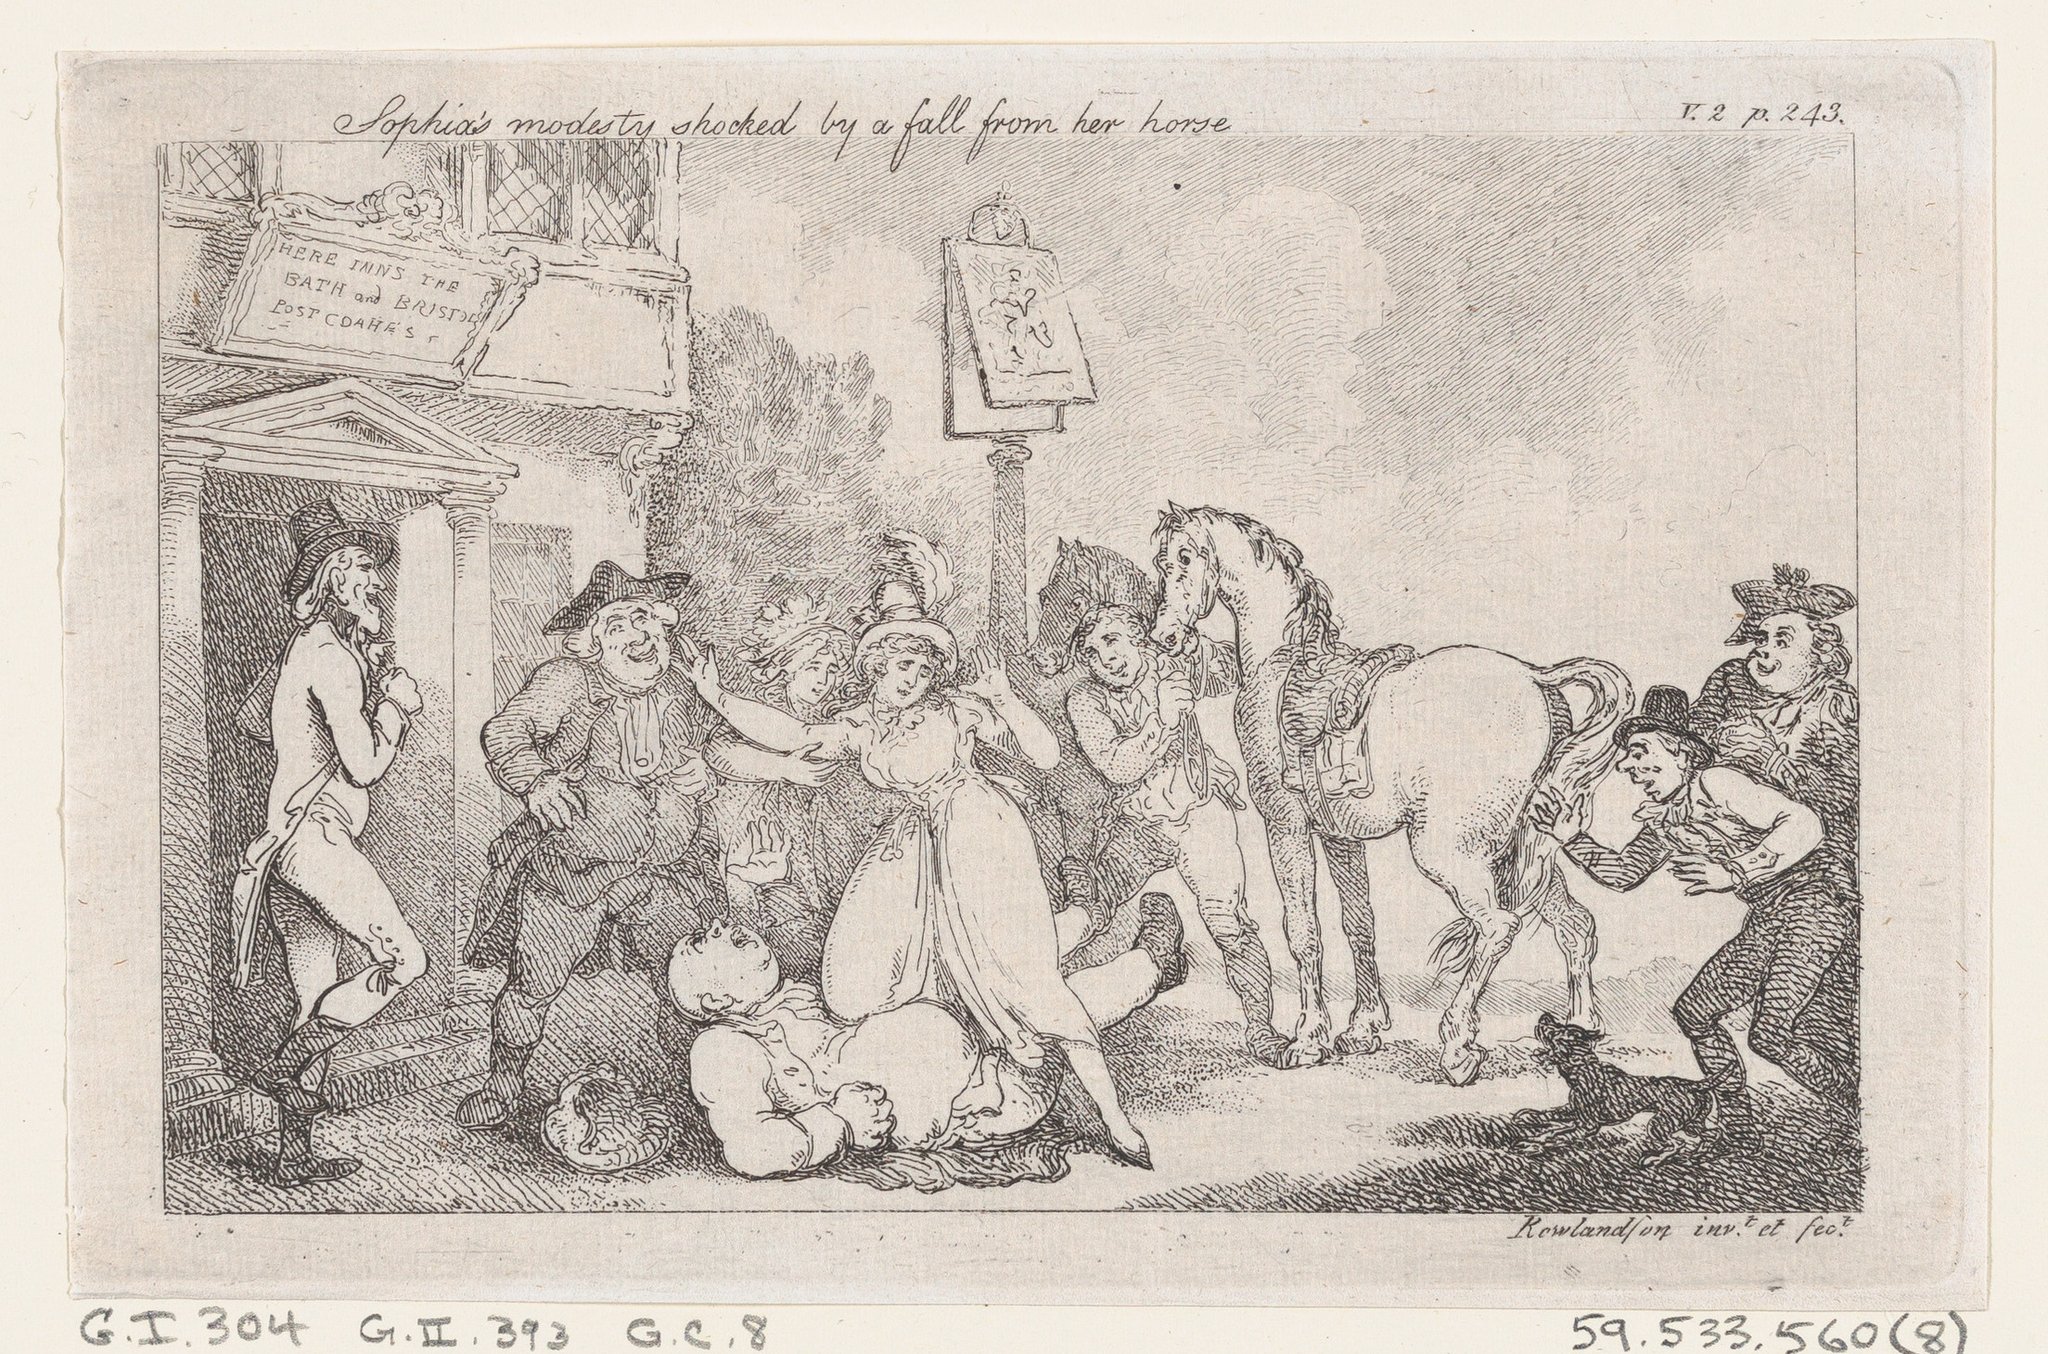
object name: print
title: Sophia's Modesty Shocked by a Fall from her Horse, from "The History of Tom Jones, a Foundling"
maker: thomas rowlandson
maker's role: artist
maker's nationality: british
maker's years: 1757-1827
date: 1792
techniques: etching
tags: men,women,horses